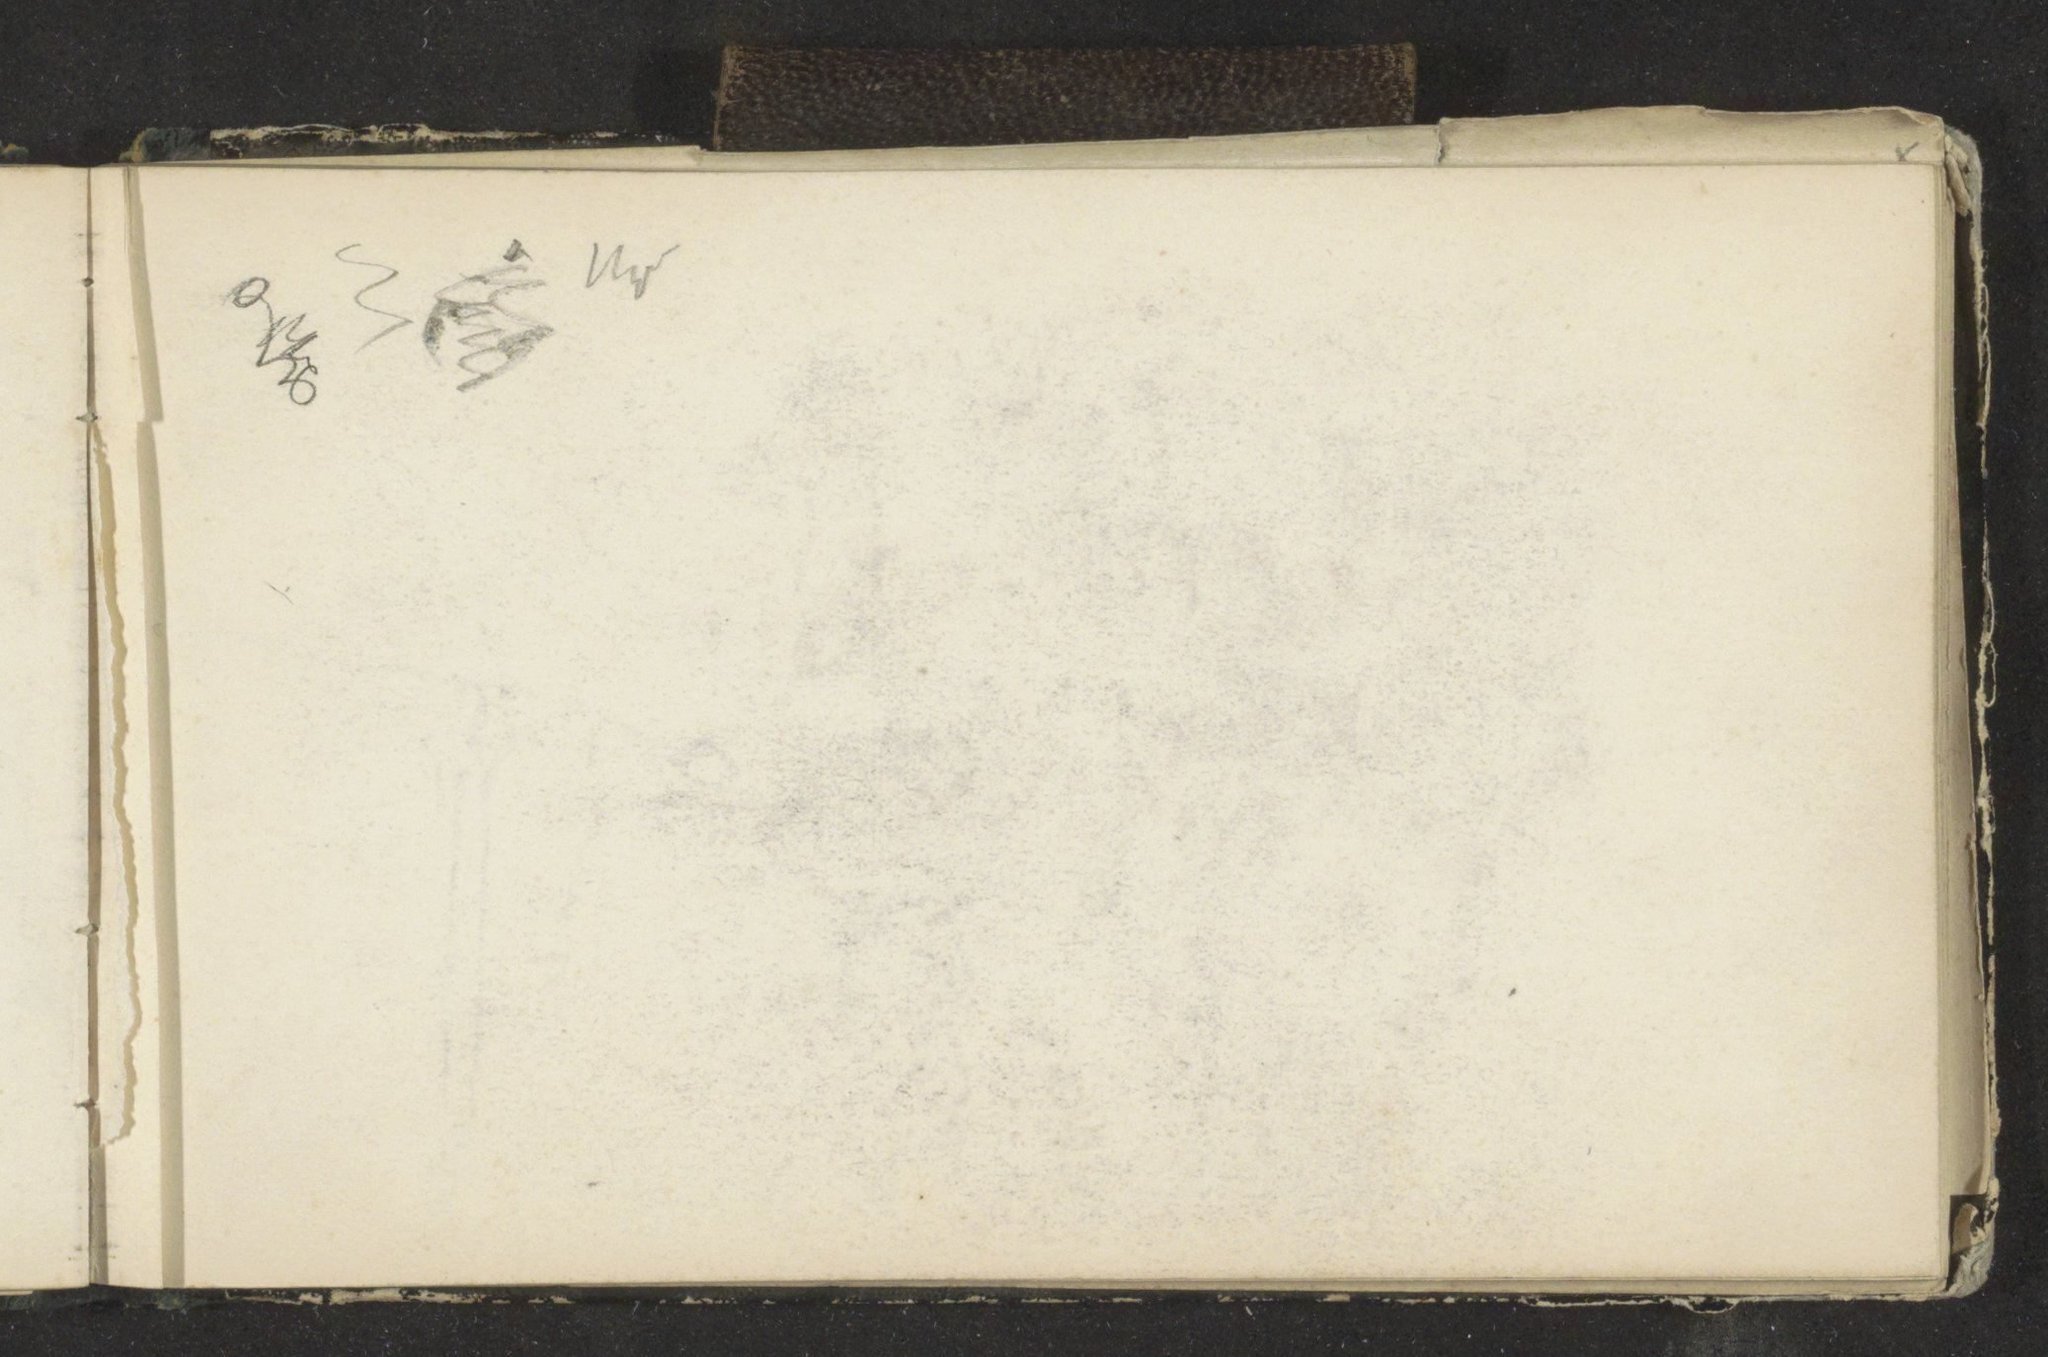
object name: sketchbook leaf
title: Studies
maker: maria vos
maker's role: draughtsman, painter, print maker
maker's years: 1824-1906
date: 1834-1906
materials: paper, pencil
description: Blad 24 recto uit een schetsboek met 46 bladen.